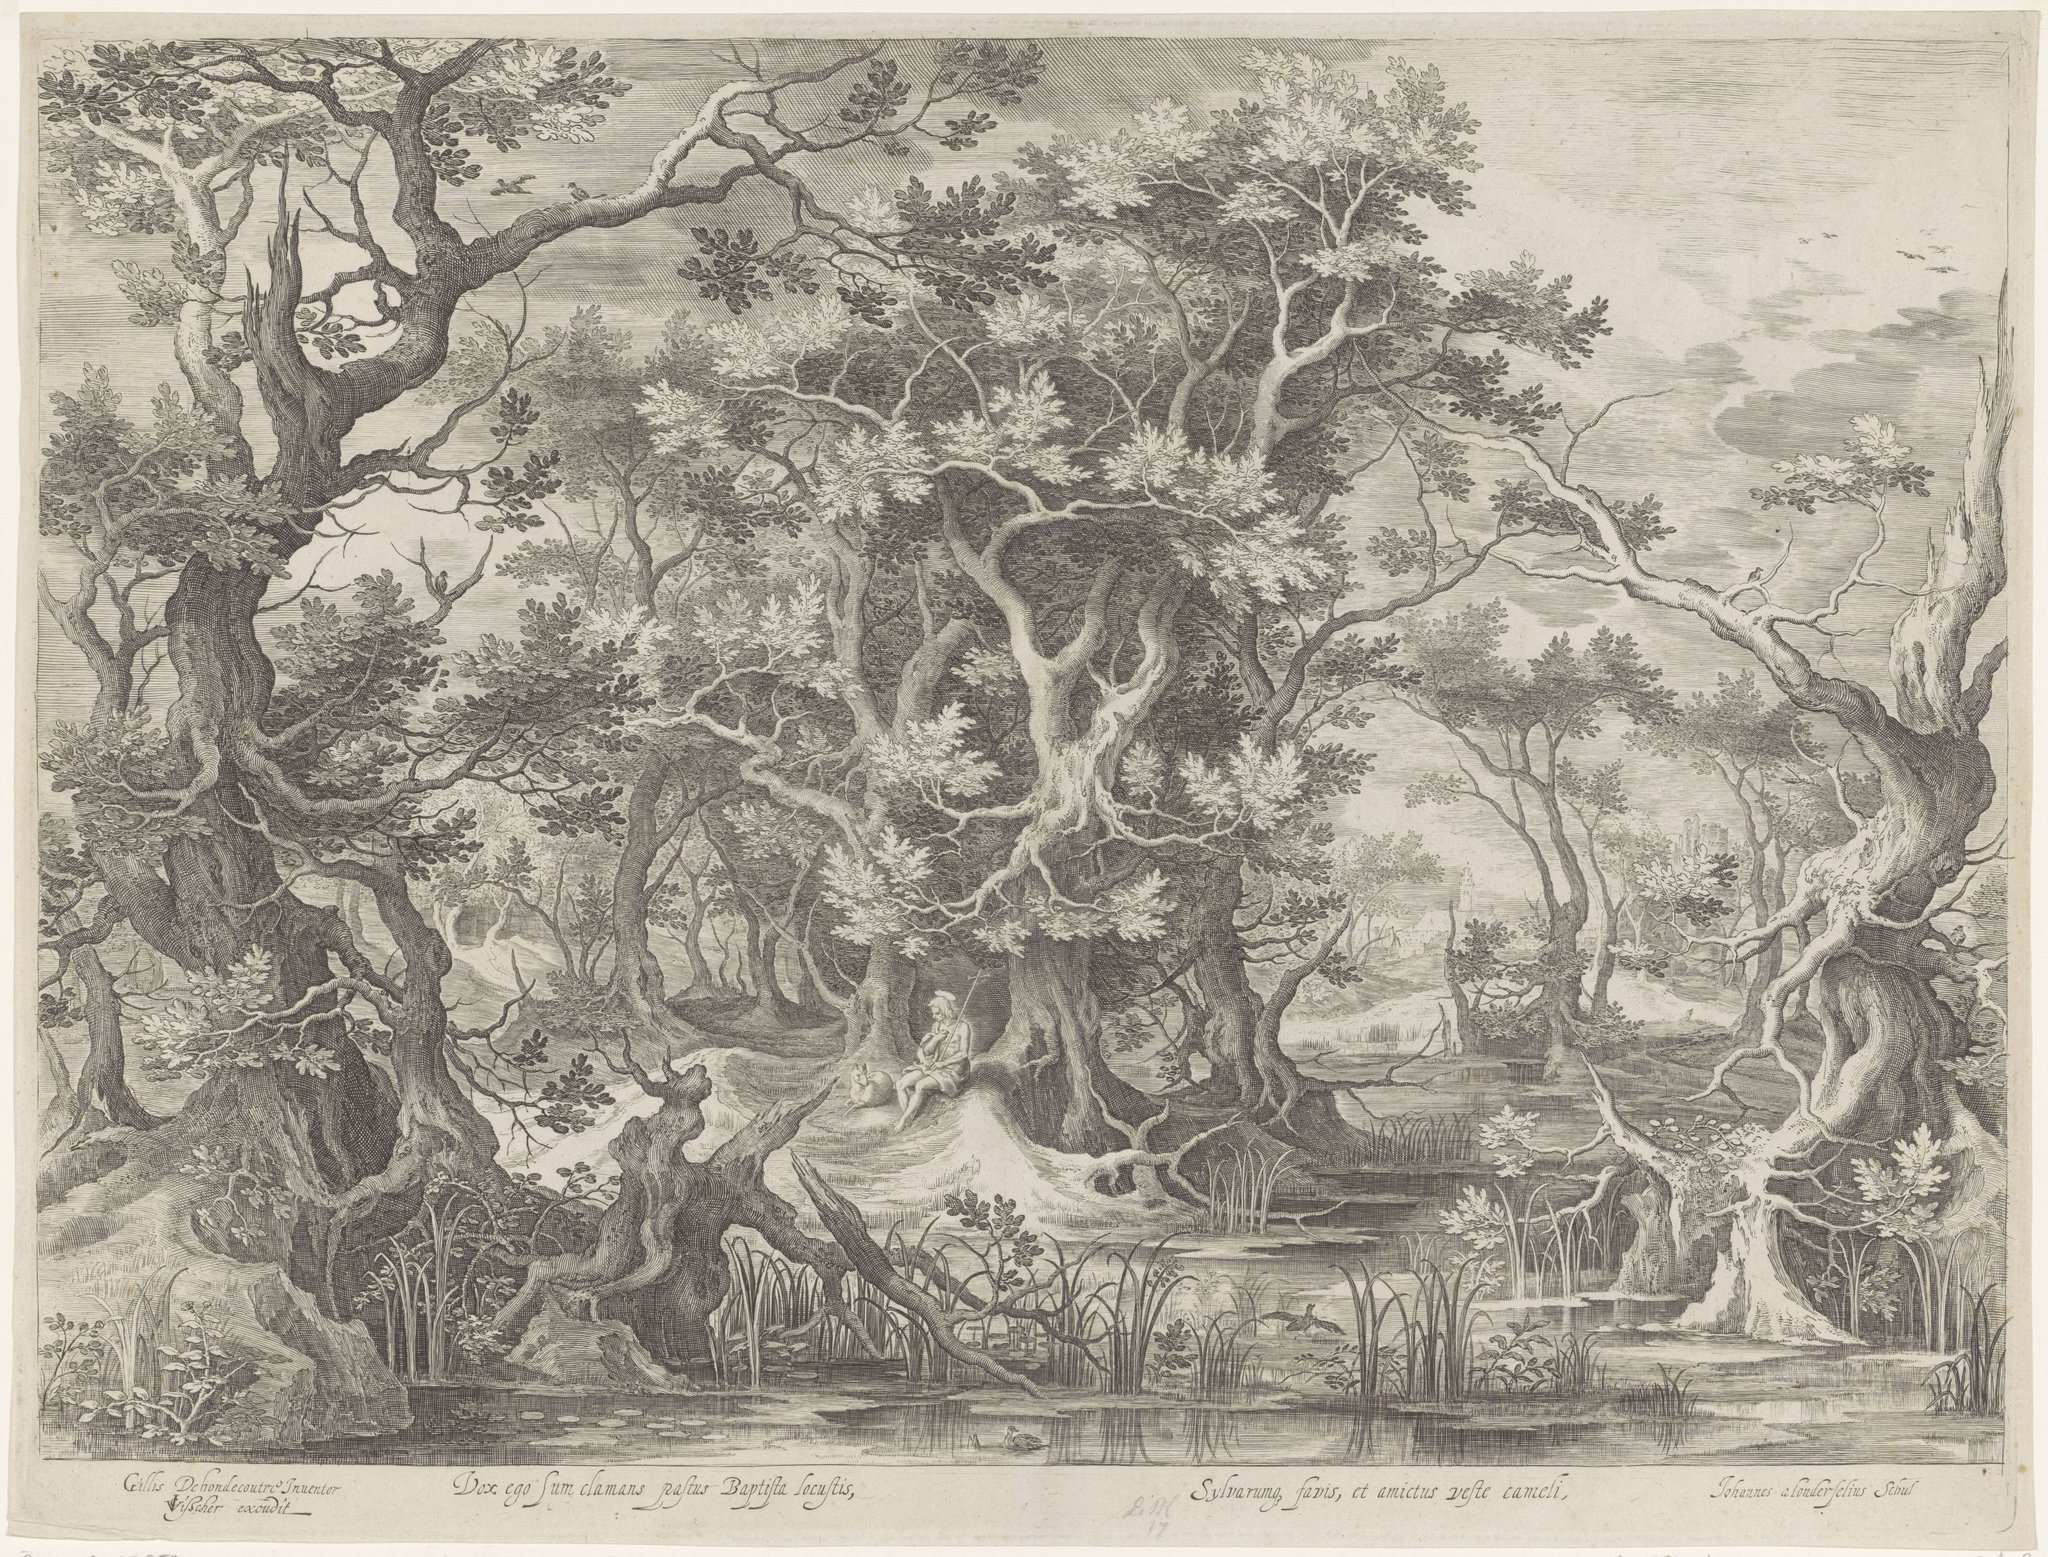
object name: print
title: Royaalbijbel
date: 1585-1625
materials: paper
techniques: engraving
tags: swamp, inland marsh, fens, john the baptist in the wilderness, usually accompanied by a lamb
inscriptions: collector's mark: Lugt 2228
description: De Amsterdamse uitgever Claes Jansz. Visscher (II) produceerde vanaf de jaren ’30 van de zeventiende eeuw grote Bijbelse prenten op zogenaamd royaal-formaat papier (ca. 480 x 580 mm). Na zijn dood in 1652 zette zijn zoon Nicolaes Visscher (I) het bedrijf voort en zo ook de uitgave van Royaalbijbelprenten. Toen Nicolaes in 1679 overleed nam zijn zoon Nicolaes Visscher (II) het bedrijf over en gaf kort hierna, omstreeks 1680, een fondslijst uit. Hierin worden 130 prenten met Bijbelse voorstellingen op royaalpapier beschreven (zie documentatie J. van der Waals). Complete prentbijbels op royaal-formaat werden door vader en zoon Nicolaes Visscher uitgegeven onder de titel Historiae Sacrae Veteris et Novi Testamenti. De bladen werden echter ook los verkocht en konden worden gecombineerd met Royaalbijbel-prenten van andere uitgevers. Verschillende Amsterdamse uitgevers brachten namelijk ook bijbelprenten op royaal-formaat uit, onder wie Clement de Jonghe en Cornelis Danckerts. De door de firma Visscher uitgegeven prenten zijn veelal vervaardigd door anonieme prentmakers naar voorbeeld van verschillende zestiende- en zeventiende-eeuwse Bijbelse prenten en prentreeksen. Veelal moesten de composities worden aangepast aan het grotere en langgerekte royaal-formaat. Daarnaast zijn er ook grote bladen van bekende prentmakers zoals Jan van Londerseel, Pieter Nolpe, Jacques de Gheyn (II) en Jan Harmensz. Muller opgenomen in de categorie ‘Bybelsche Figuren, op Royaal-bladen’ in de fondslijst van Visscher. Prent mogelijk gebruikt in: Historiae Sacrae Veteris et Novi Testamenti (Royaalbijbel). Amsterdam: Nicolaes Visscher (I) en (II), [1652-1702]. In de fondslijst van Nicolaes Visscher II (ca. 1680) is het onderwerp van deze prent onder de titel 'Bybelsche Figuren, op Royaal-bladen. bestaande uyt de volgende historien.' als volgt genummerd: 74.